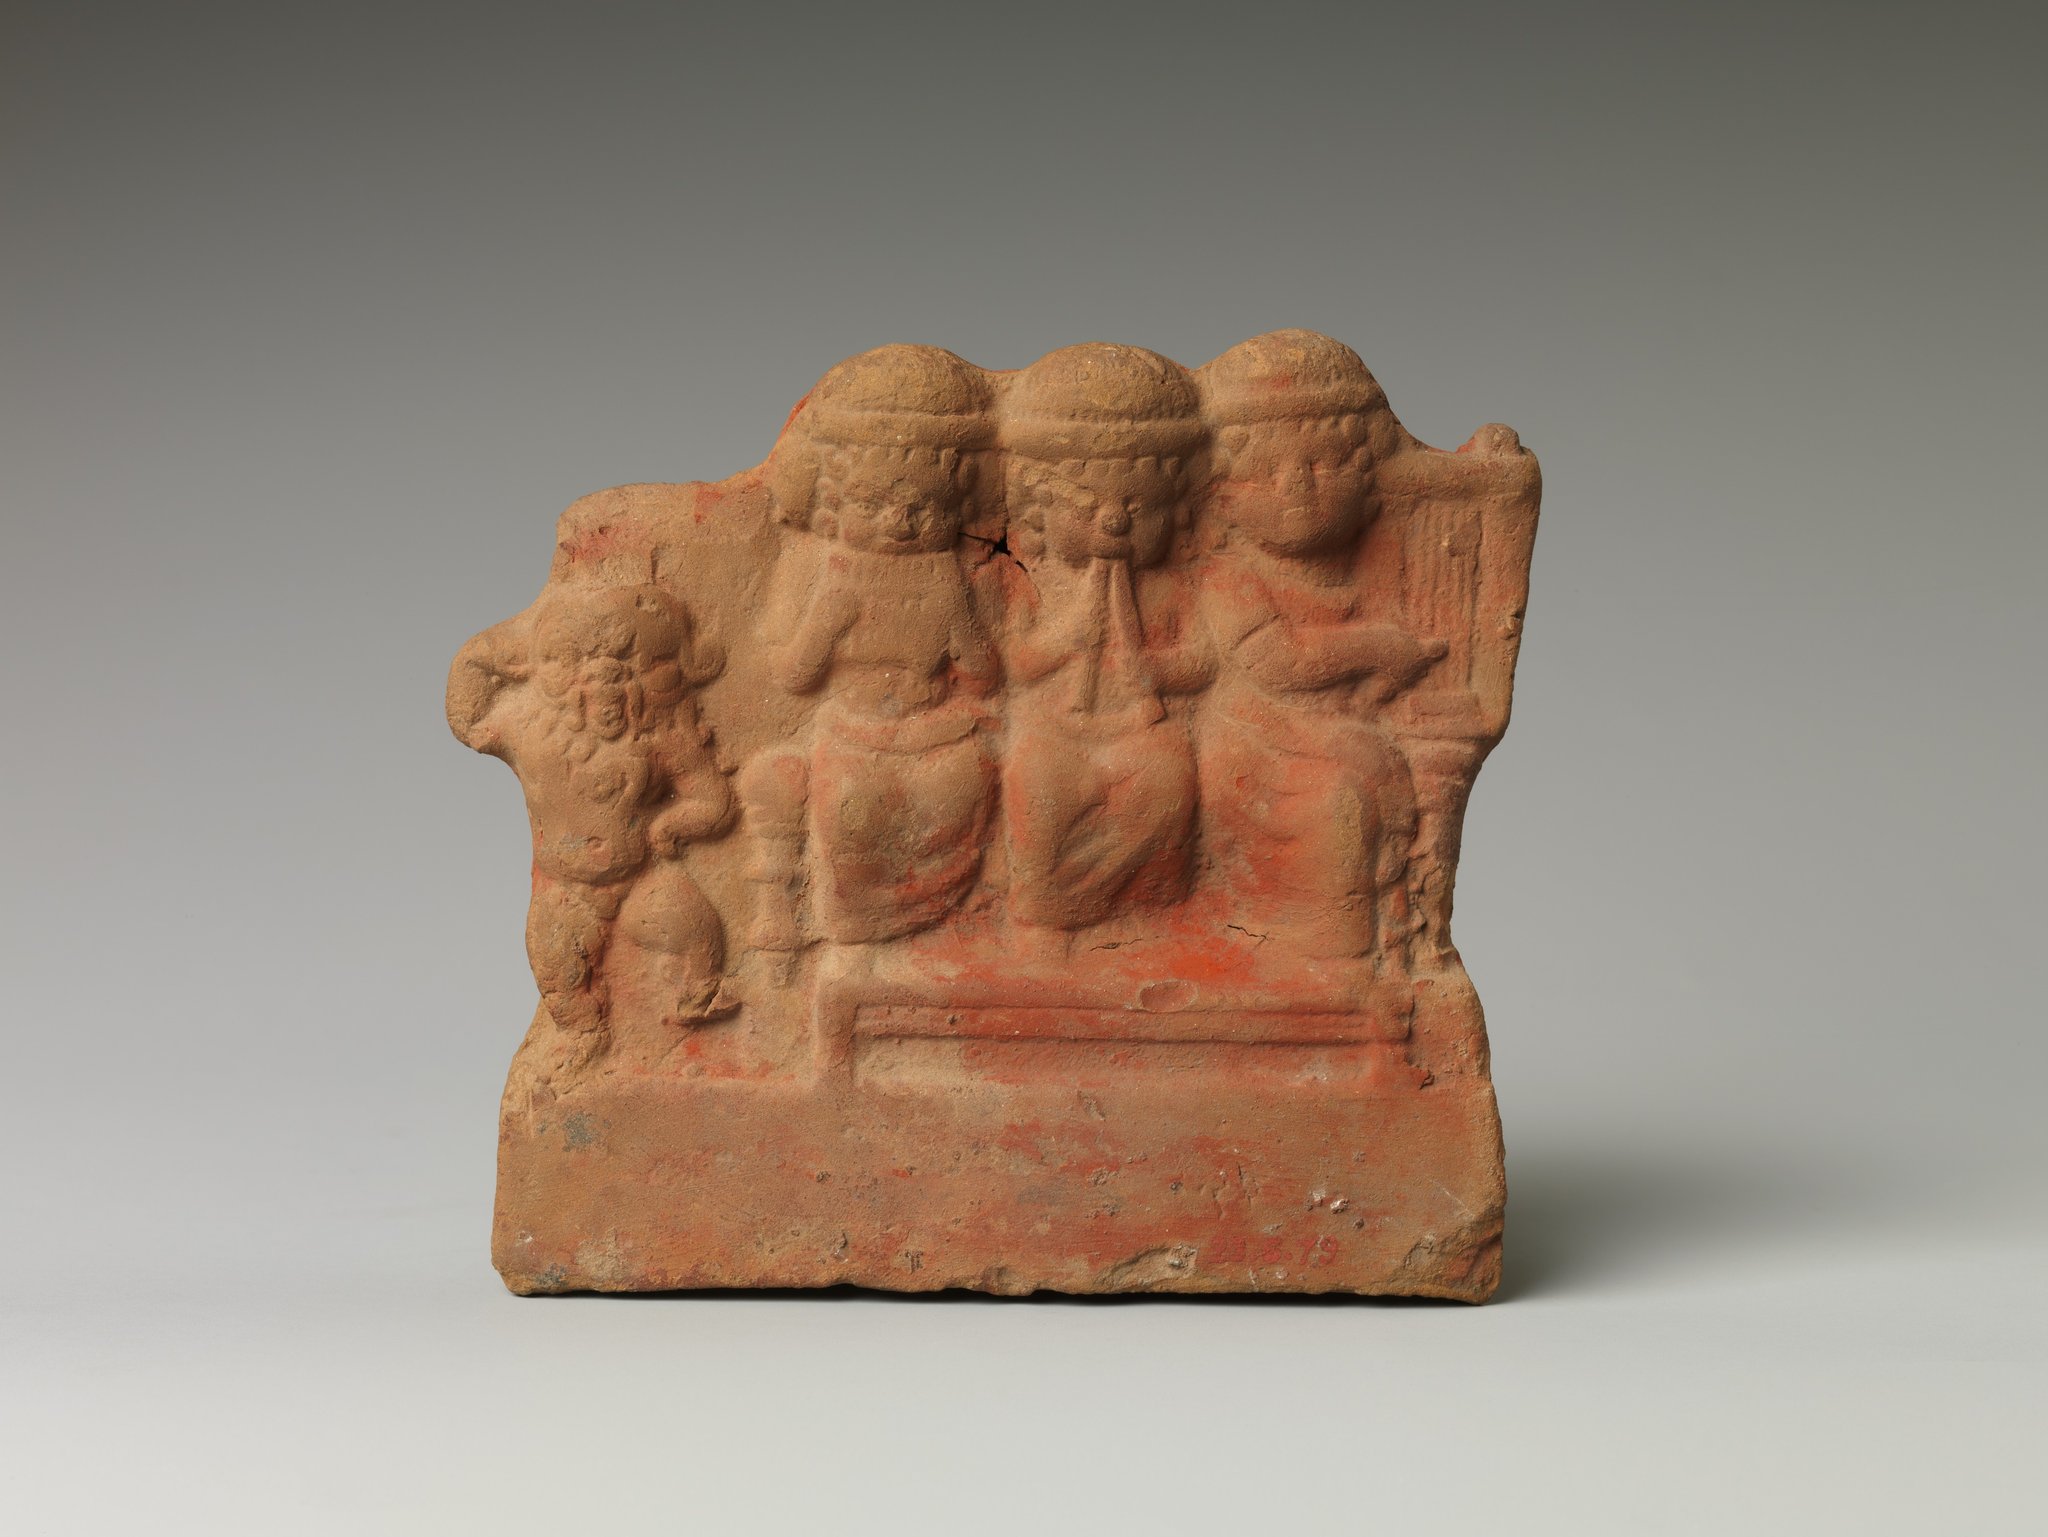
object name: figurine group, be, musician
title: Dancing Bes alongside seated group of musicians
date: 332-330 BCE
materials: pottery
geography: egypt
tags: dancing,music,bes,musicians